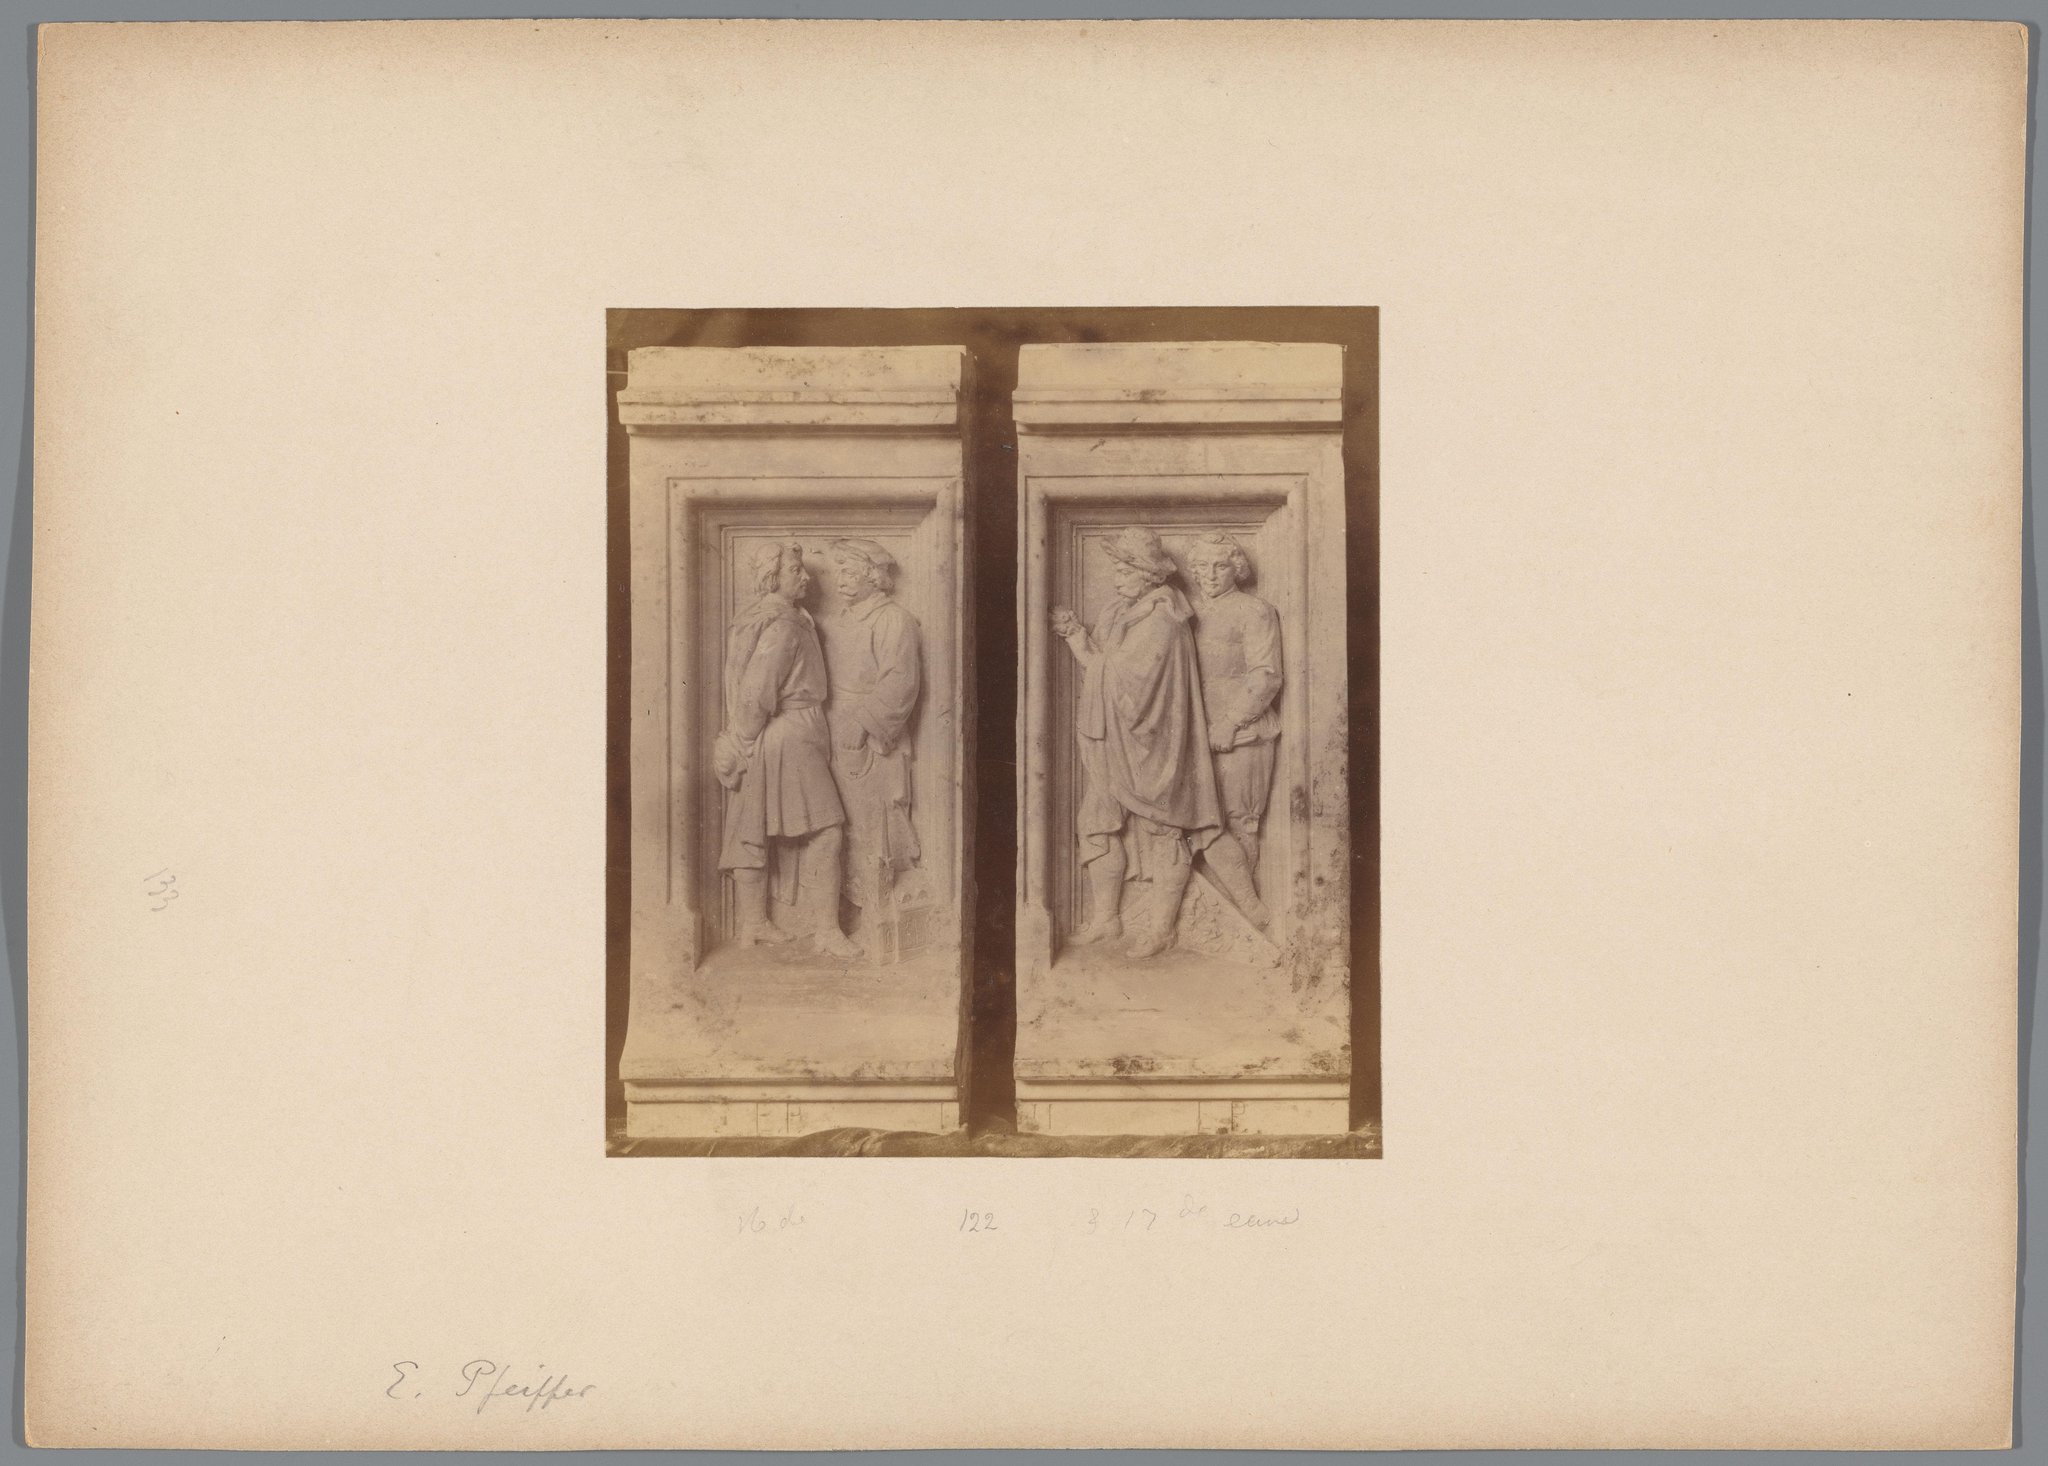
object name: reproduction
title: Fotoreproductie van beeldhouwwerken met vier kunstenaars uit de zestiende en zeventiende eeuw door Ernst Pfeifer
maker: Anonymous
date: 1880-1887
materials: cardboard, paper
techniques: albumen print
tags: the arts; artists, piece of sculpture, reproduction of a piece of sculpture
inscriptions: inscription: ‘16de & 17de eeuw/ 122/ 133’, inscription: ‘E. Pfeiffer’, collector's mark: Lugt 2228